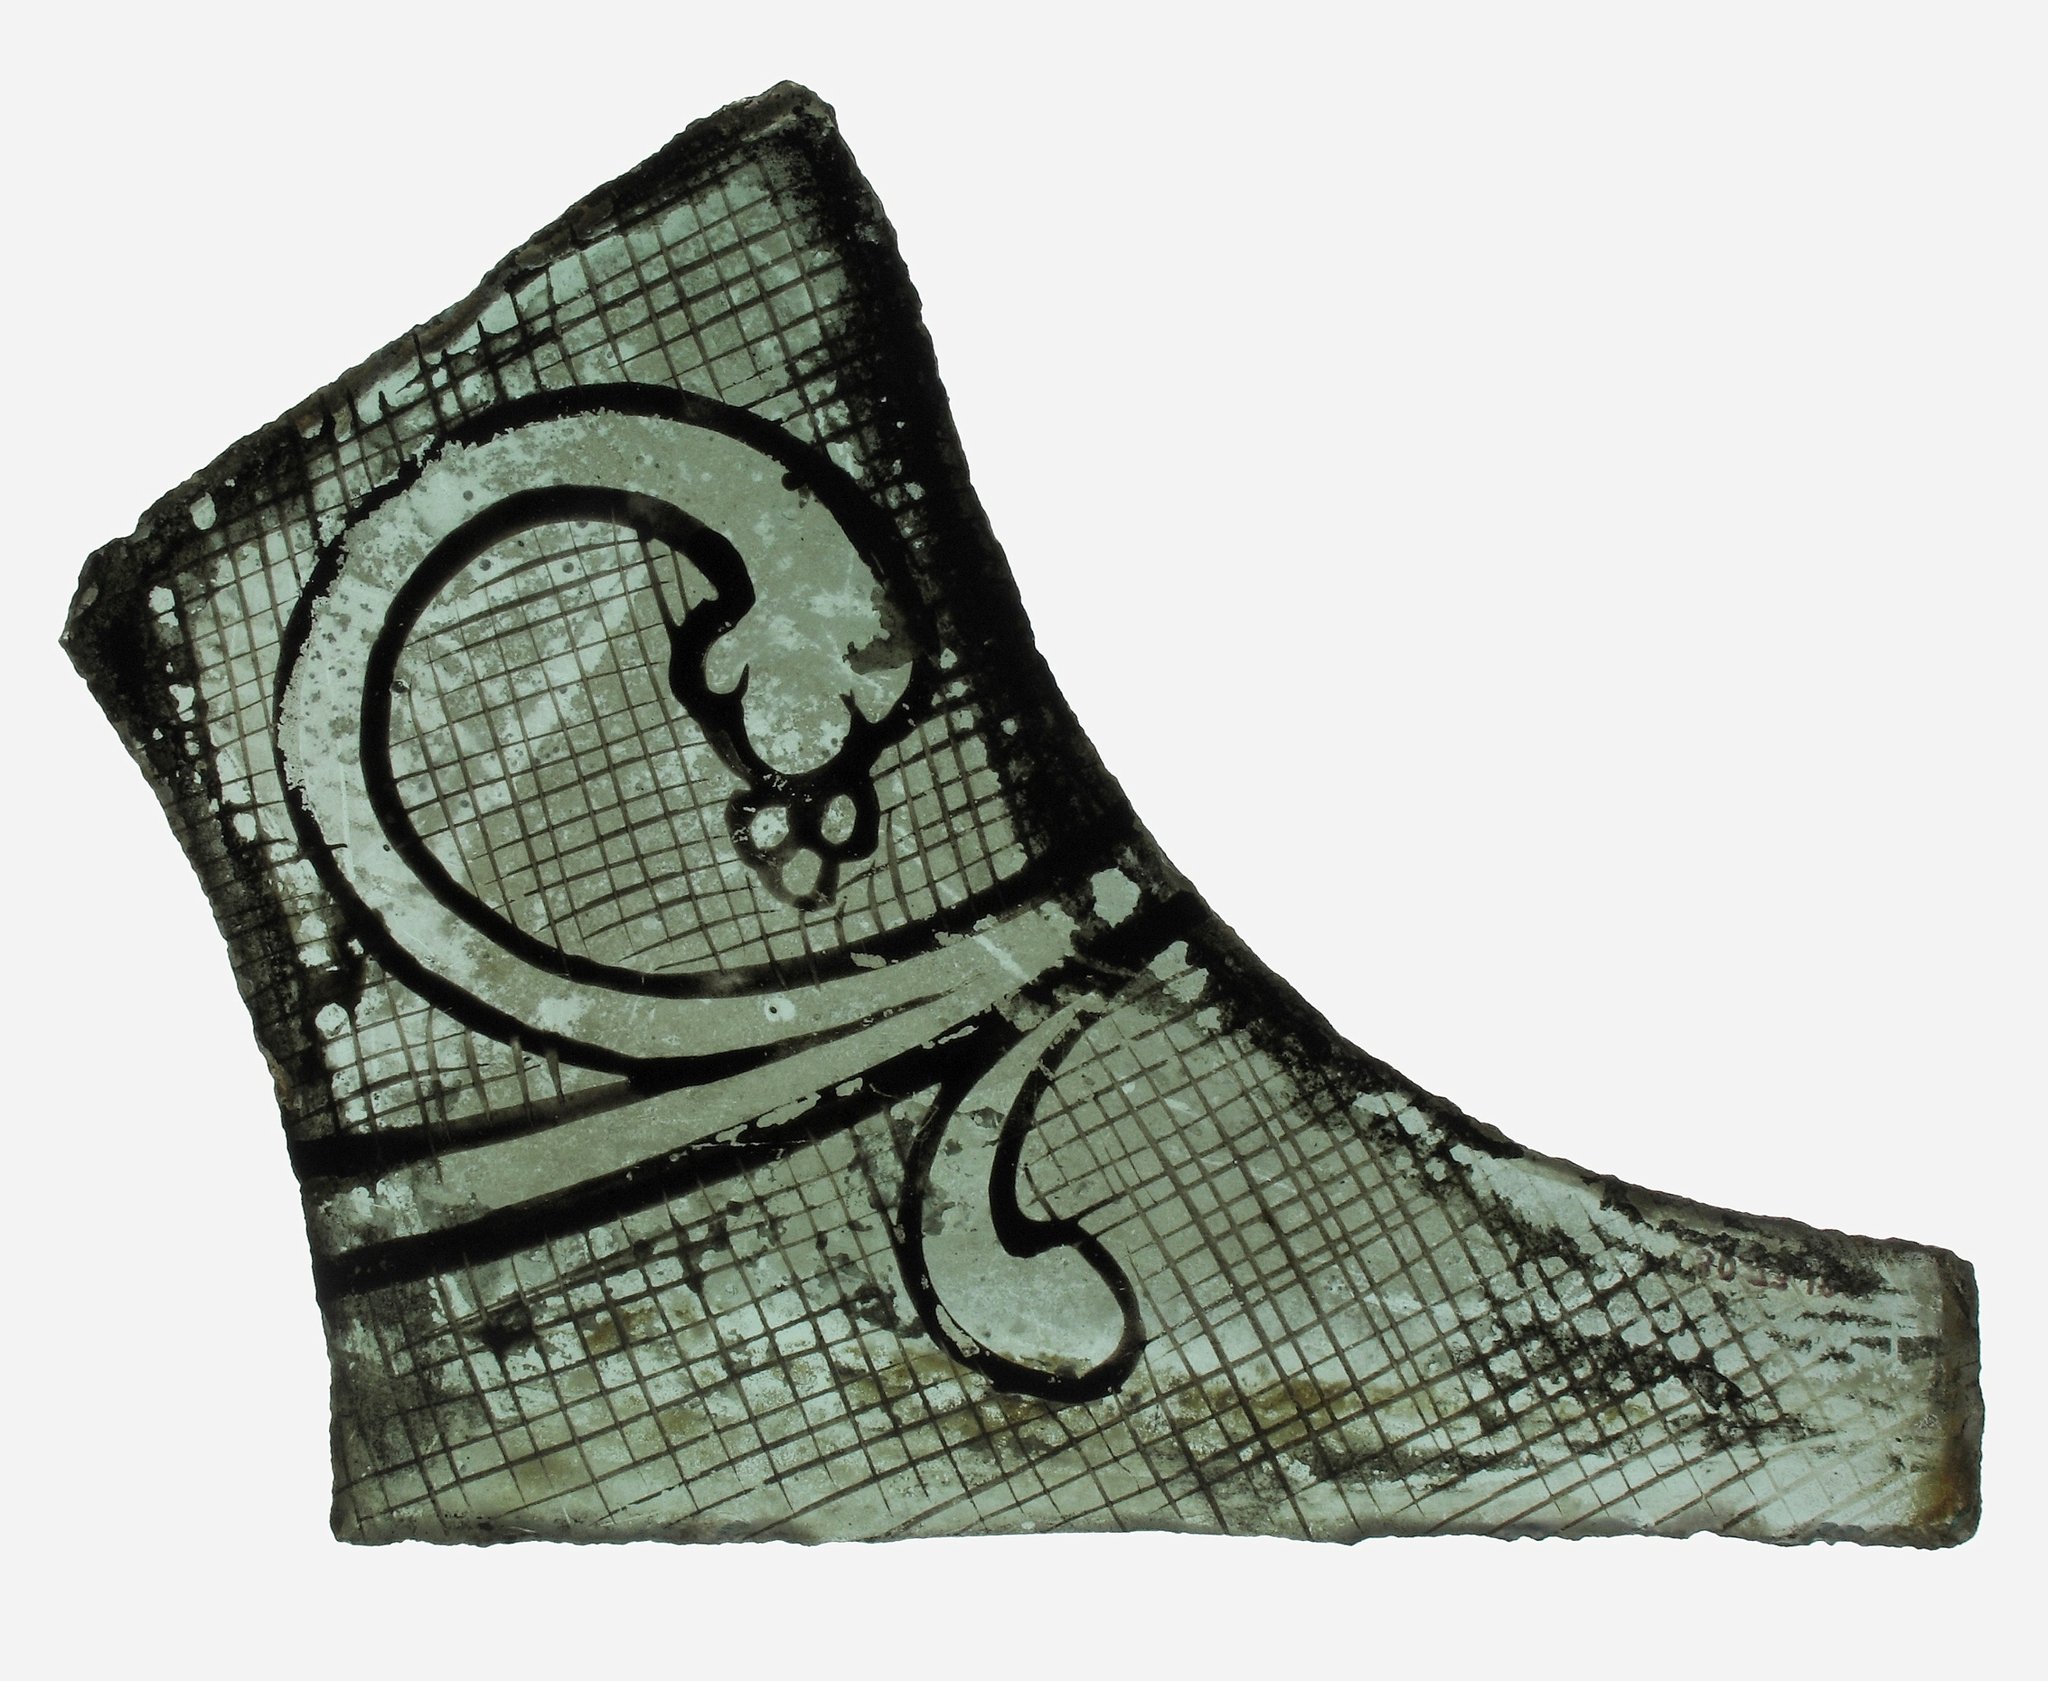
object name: fragment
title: Glass Fragment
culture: french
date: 1201-1400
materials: glass